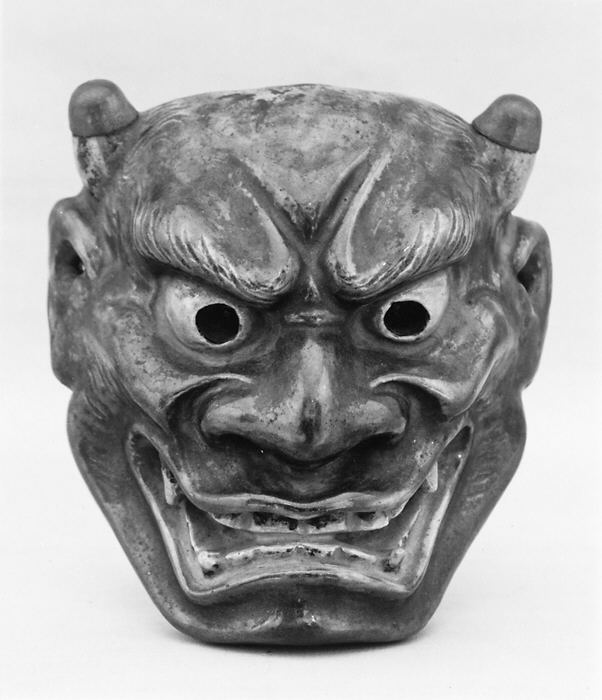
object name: hanging vase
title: Hanging Flower Vase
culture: japanese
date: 1701-1800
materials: clay, glaze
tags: demons